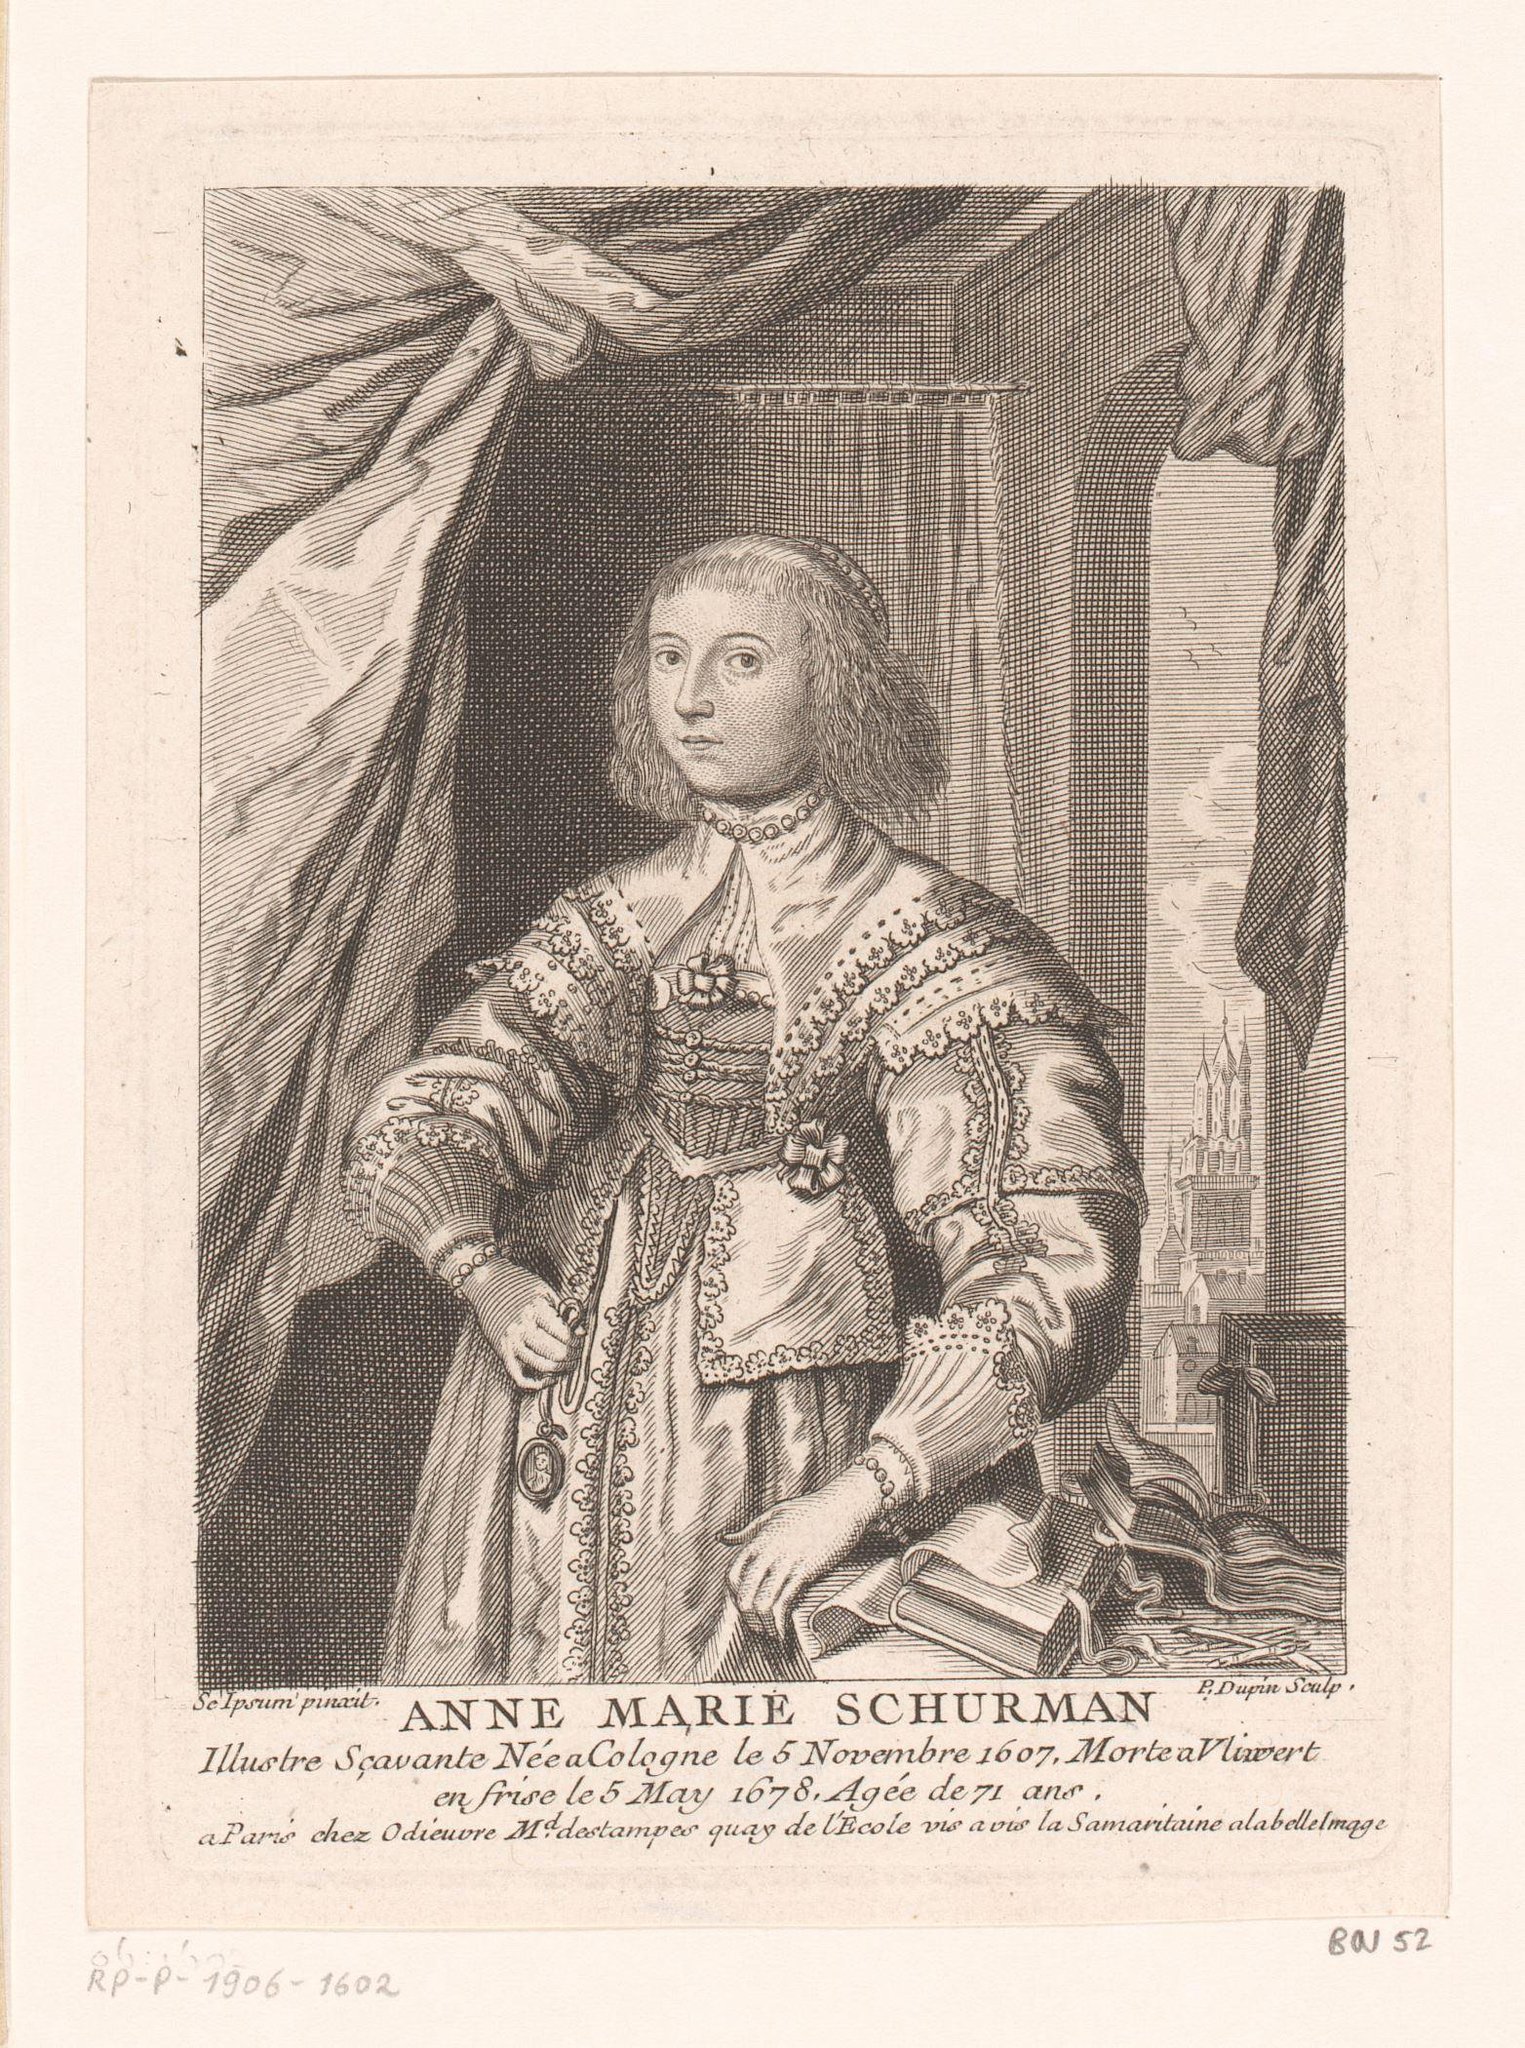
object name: book illustration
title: Portret van Anna Maria van Schurman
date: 1755-1765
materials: paper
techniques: engraving, etching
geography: paris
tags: cologne, draughtsman, anna maria van schurman, theologian, historical persons - bb - woman, scholar, philosopher, portrait, self-portrait of artist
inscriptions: collector's mark: Lugt 2228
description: Prent uit: Dreux du Radier, Jean-François. L'Europe illustré, contenant l'histoire abregée des souverains, des princes, des prélats, des ministres, (...) en Europe: dans le XVe. siècle compris, jusqu'à présent. Parijs: Michel Odieuvre en Jean-Luc Nyon, 1755-1765, dl. 4.